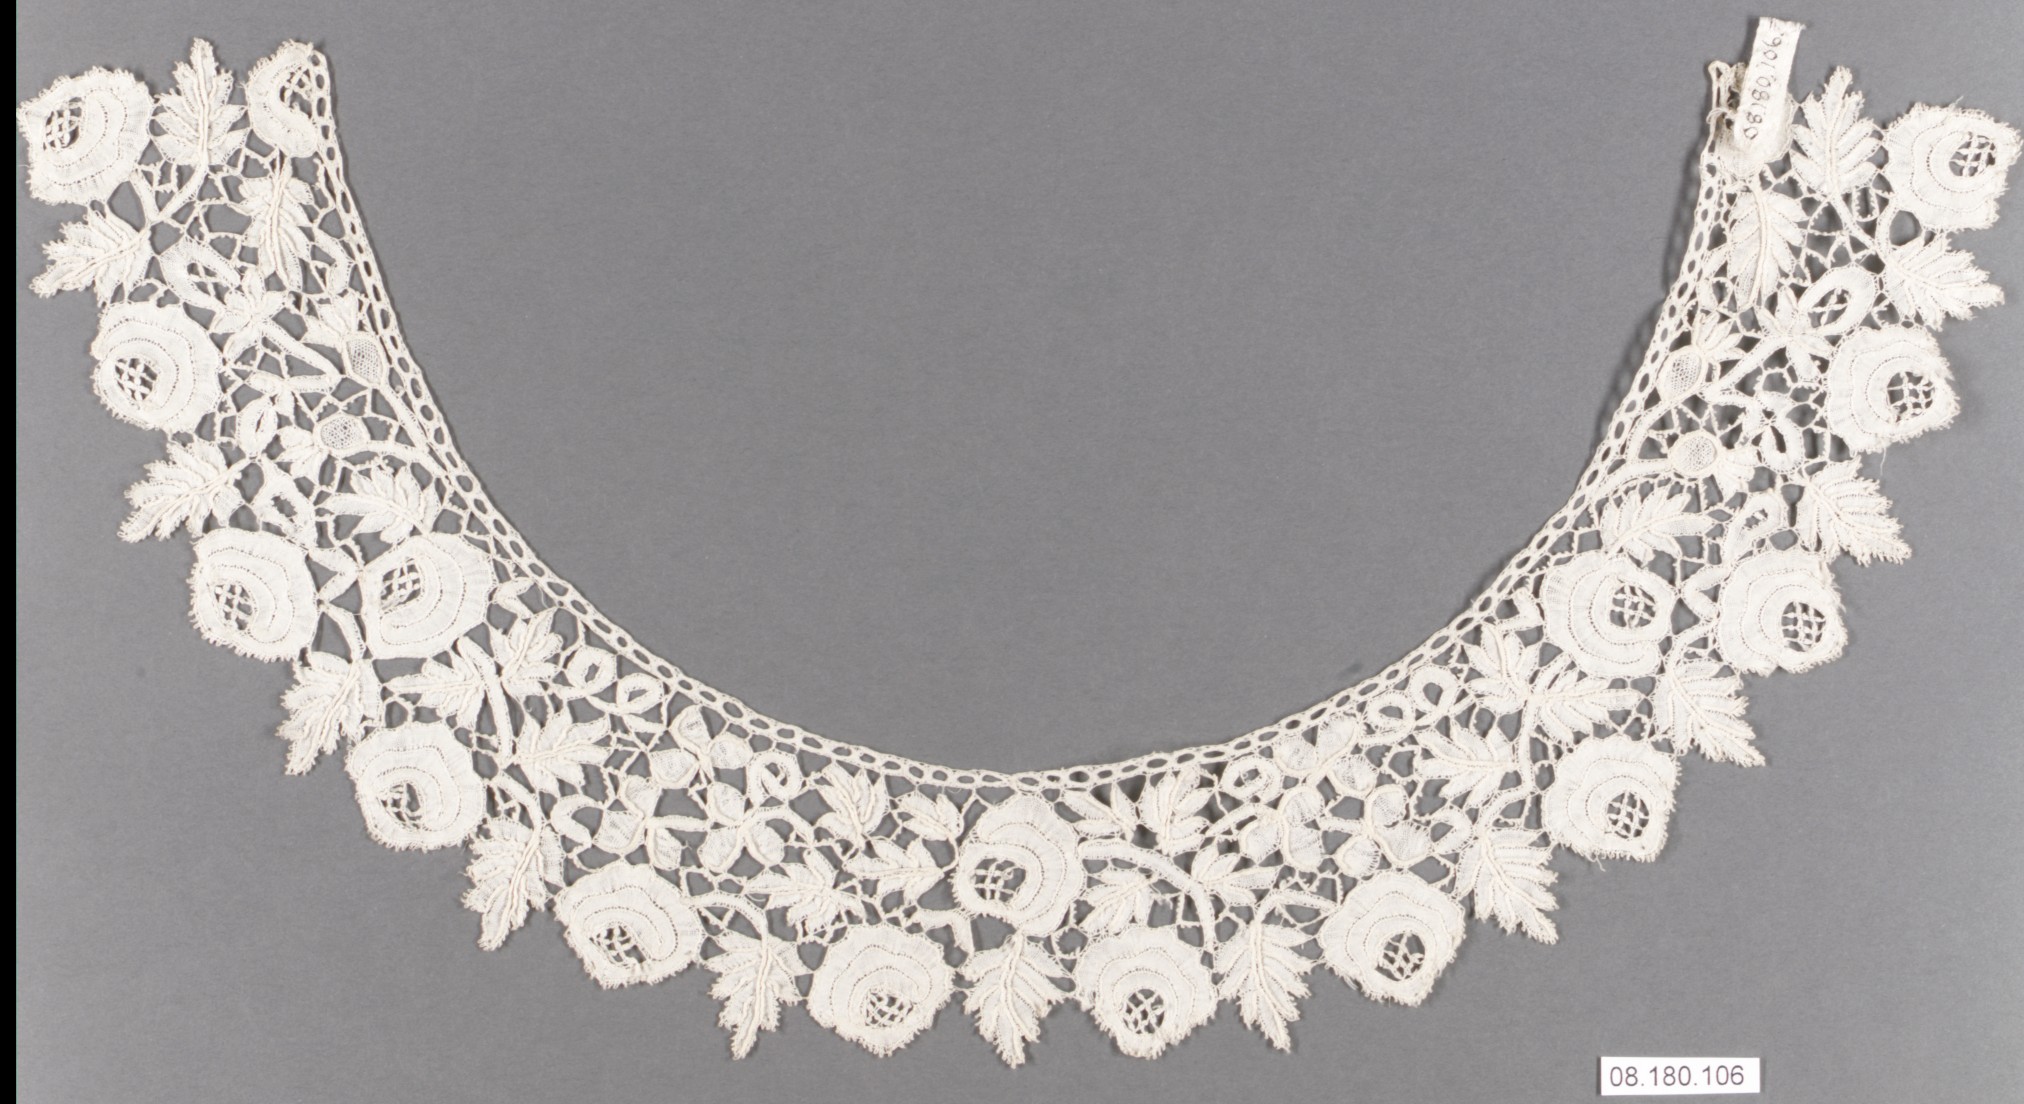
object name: collar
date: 1801-1900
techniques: lace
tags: flowers